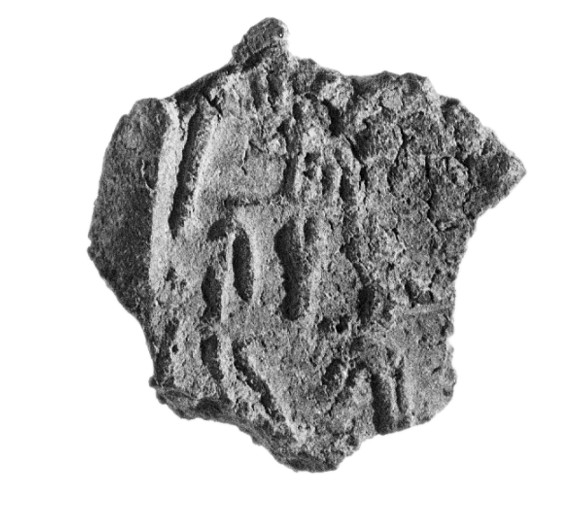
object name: sealing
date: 1981-1640 BCE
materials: mud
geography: egypt